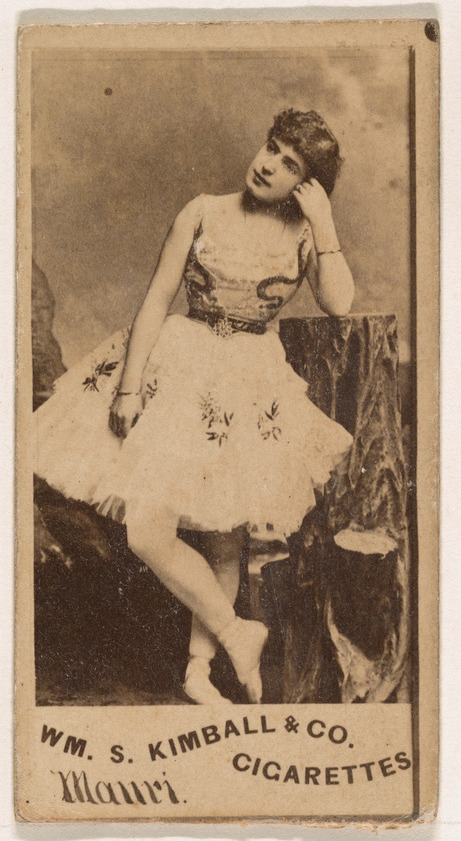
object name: photograph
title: Miss Mauri, from the Actresses series (N203) issued by Wm. S. Kimball & Co.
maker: william s. kimball & company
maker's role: publisher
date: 1889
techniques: color lithograph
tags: portraits,women,actresses